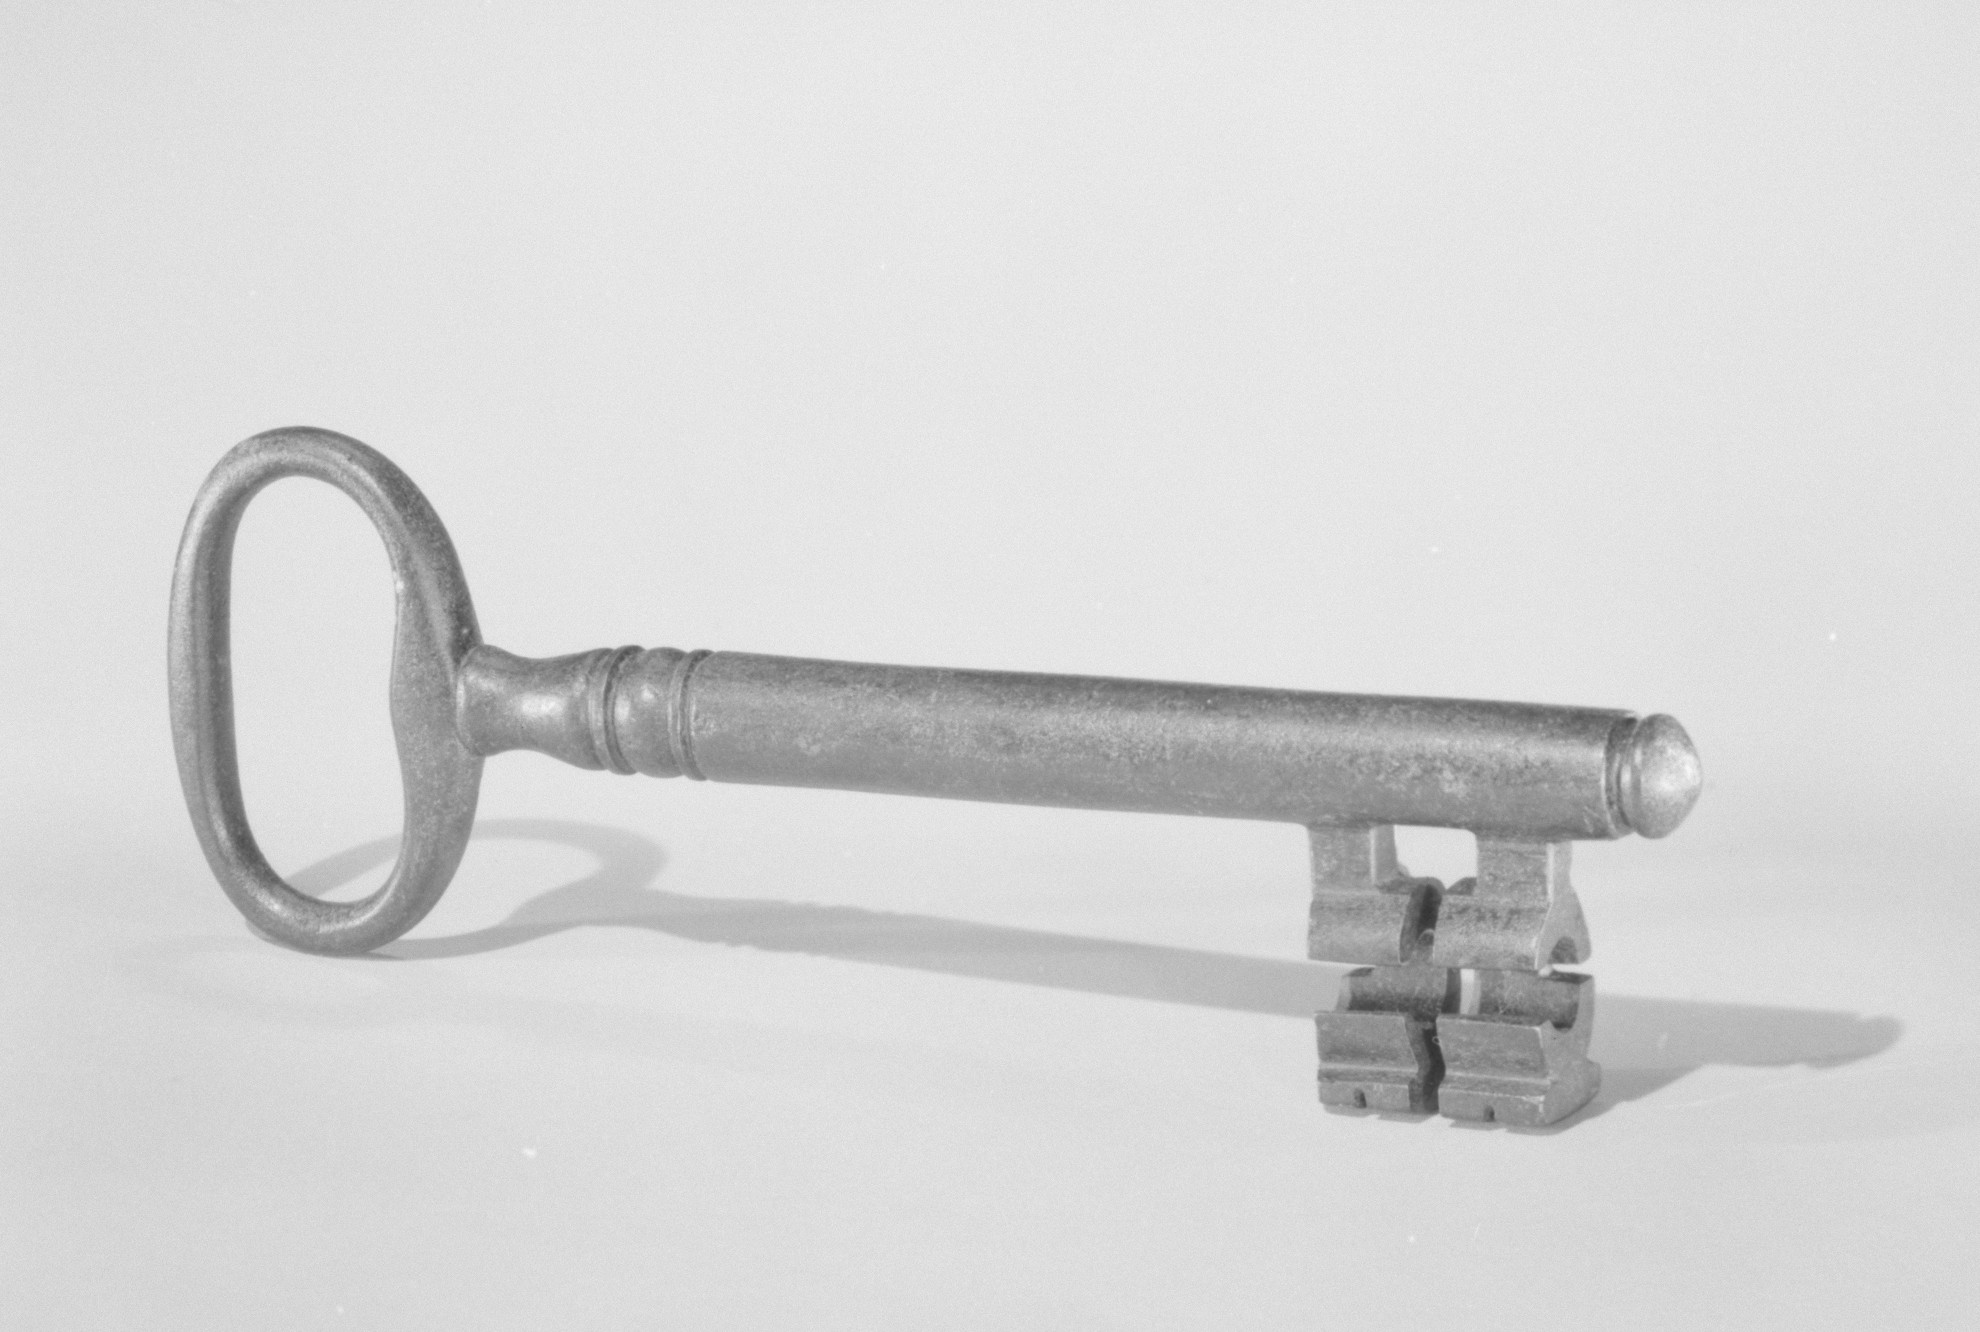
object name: key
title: Pin key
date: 1667-1800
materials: iron